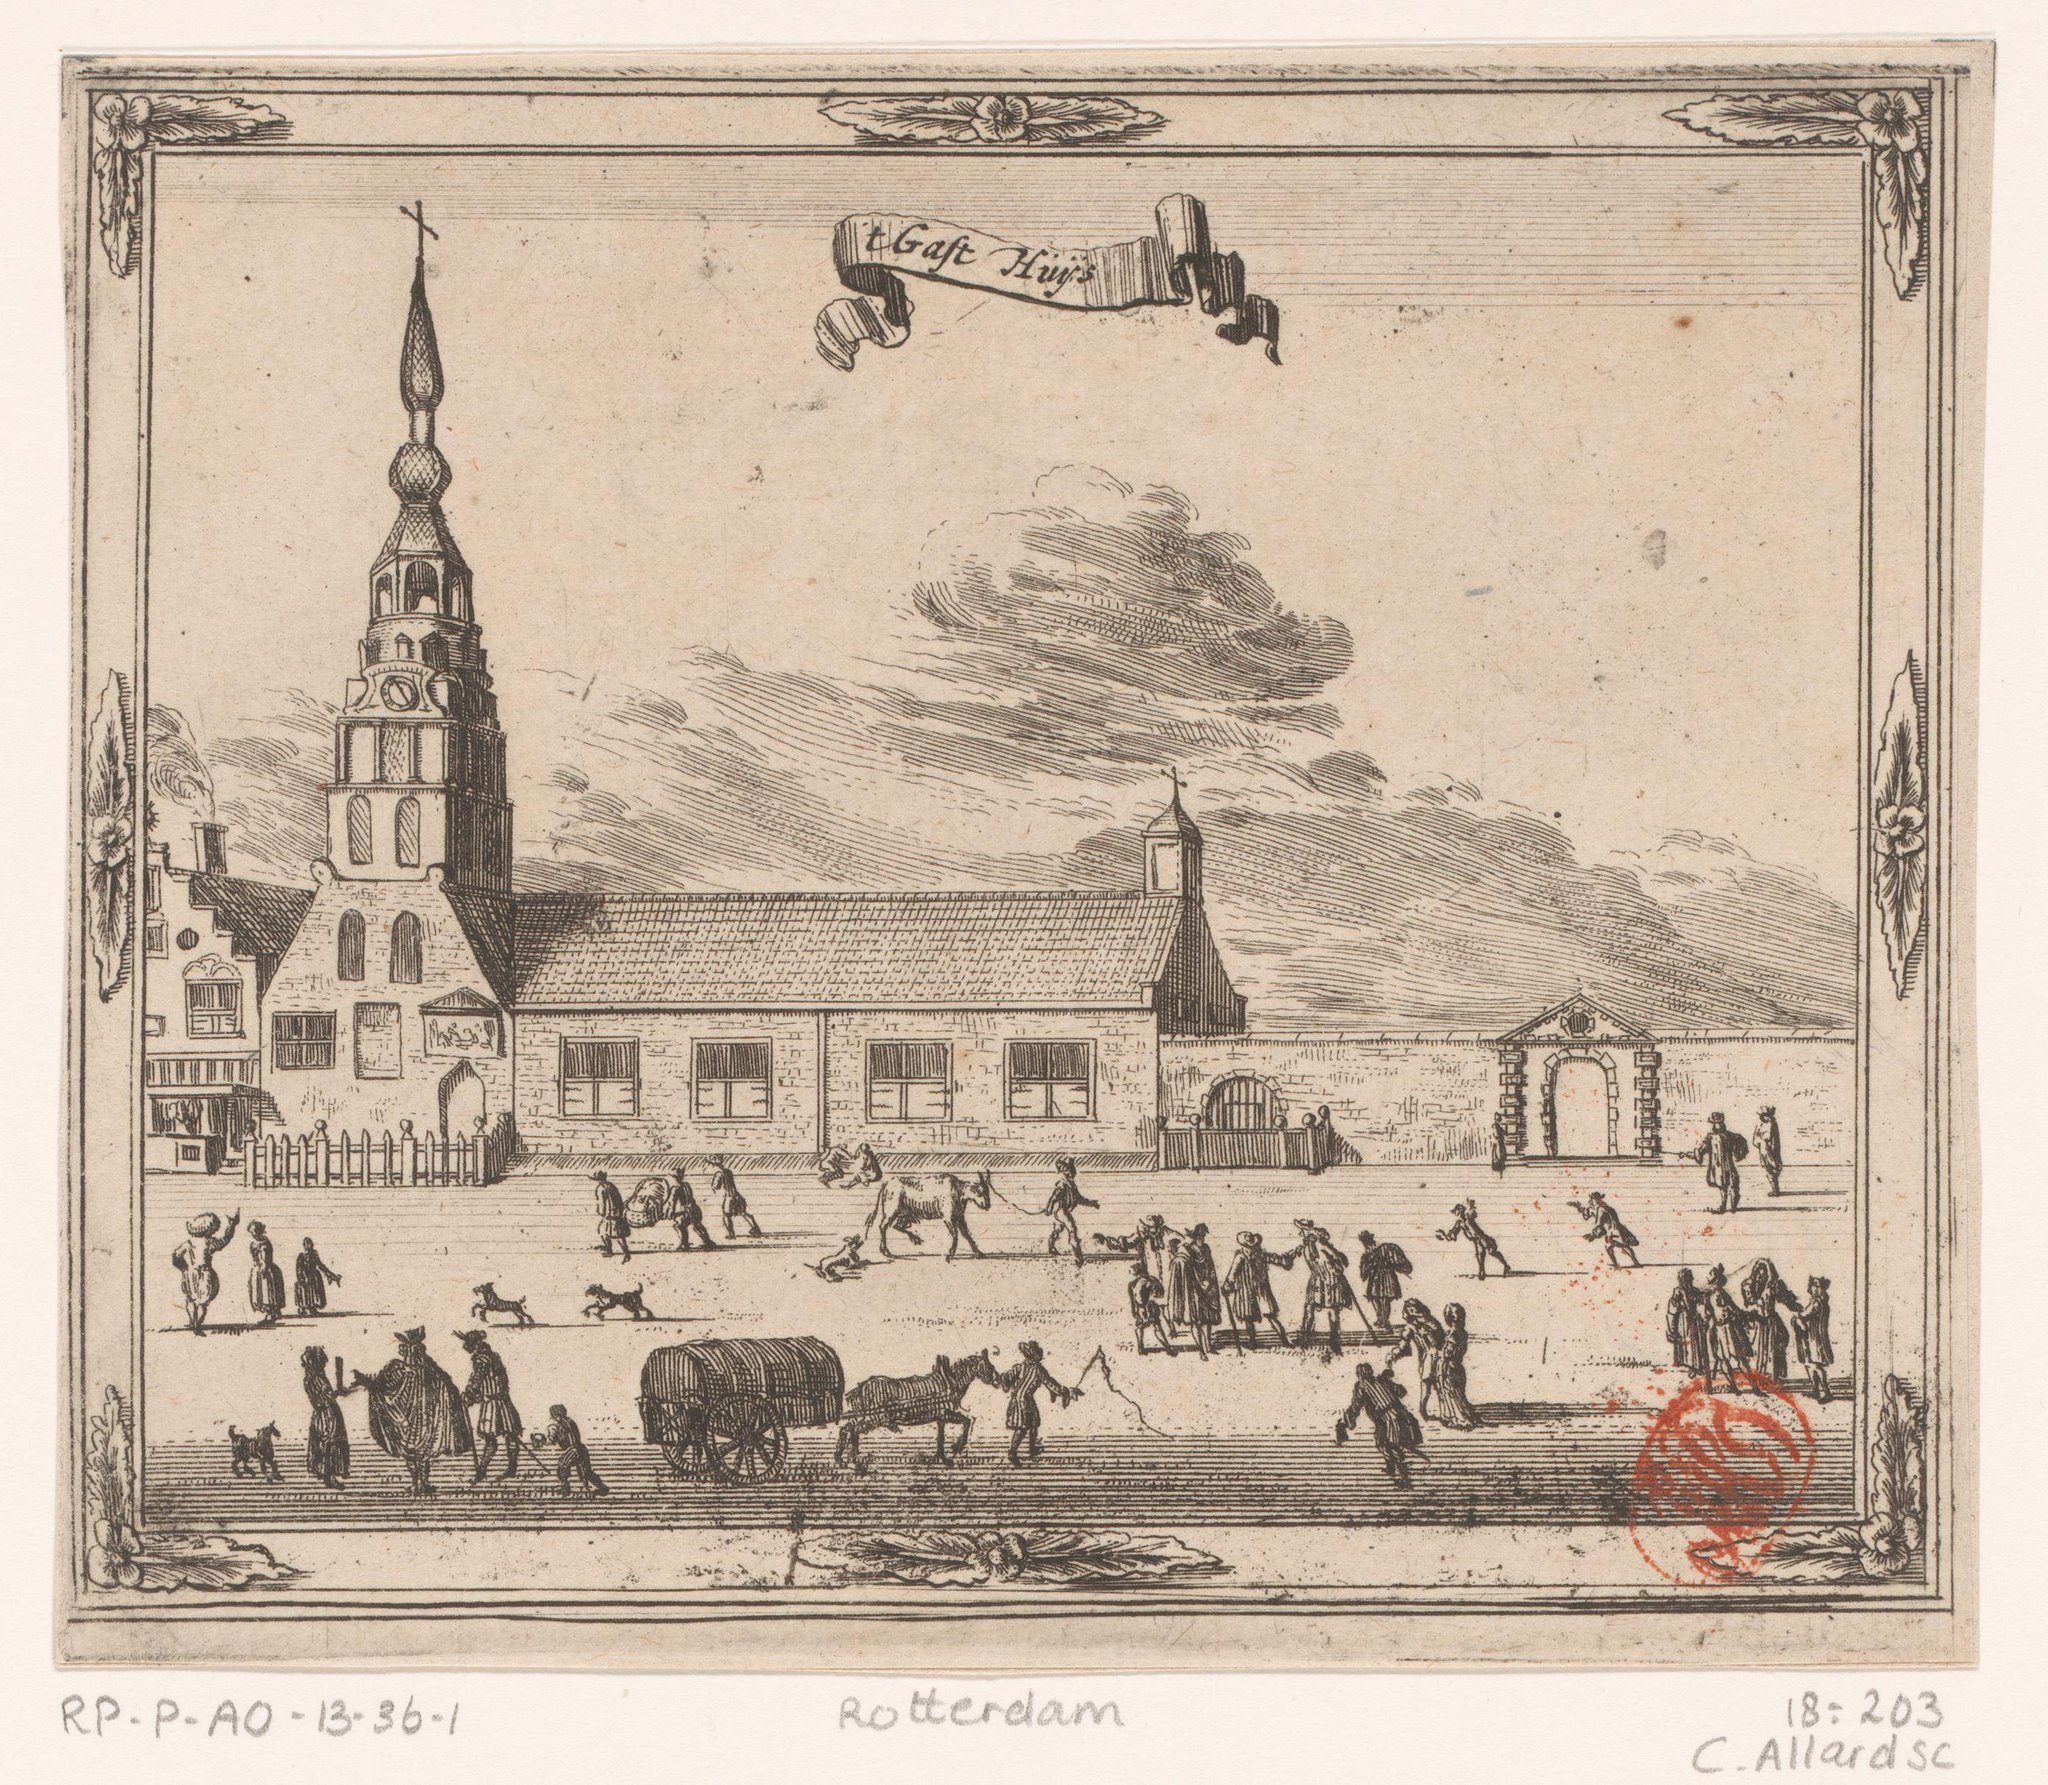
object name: print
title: Gezicht op het Gasthuis te Rotterdam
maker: jacobus harrewijn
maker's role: print maker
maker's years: 1660-1740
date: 1715-1730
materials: paper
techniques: etching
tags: hospital, street (+ city(-scape) with figures, staffage)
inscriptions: collector's mark: Lugt 195, collector's mark: Lugt 2228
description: Prent vermoedelijk eerst met dertien andere stadsgezichten uitgegeven als onderdeel van de sierrand van – in ieder geval de derde staat en mogelijk ook de tweede van – de plattegrond 'Tabula Roterodami Novissima' (zie RP-P-AO-13-11). Later nog een keer als onderdeel van een prentserie uitgegeven: Les principaux edifices et vues de la ville de Rotterdam. Le tout fidèlement dessiné sur les lieux. Leiden: Pieter van der Aa, s.a. [adres 'dans l'Academie', dus 1715-1730]. De platen zijn voor zover na te gaan ongewijzigd gebleven.